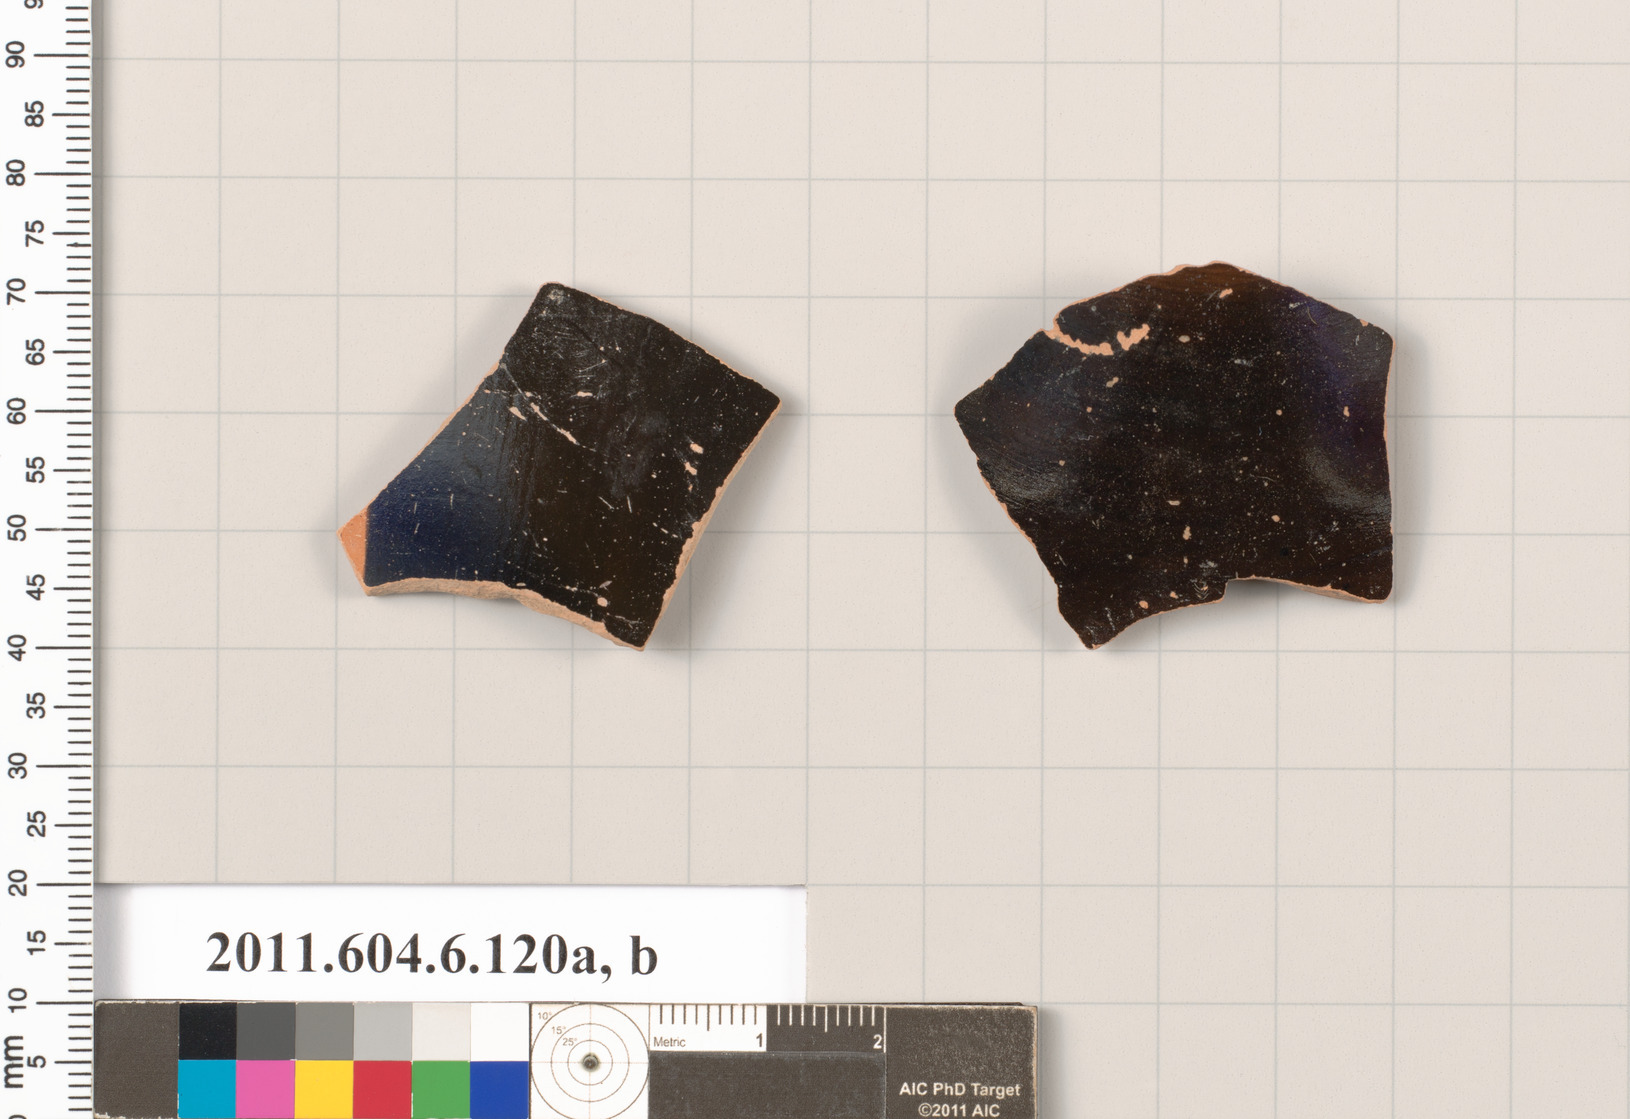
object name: undetermined closed shape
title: Terracotta fragments of closed shapes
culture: greek, attic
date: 600-401 BCE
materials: terracotta